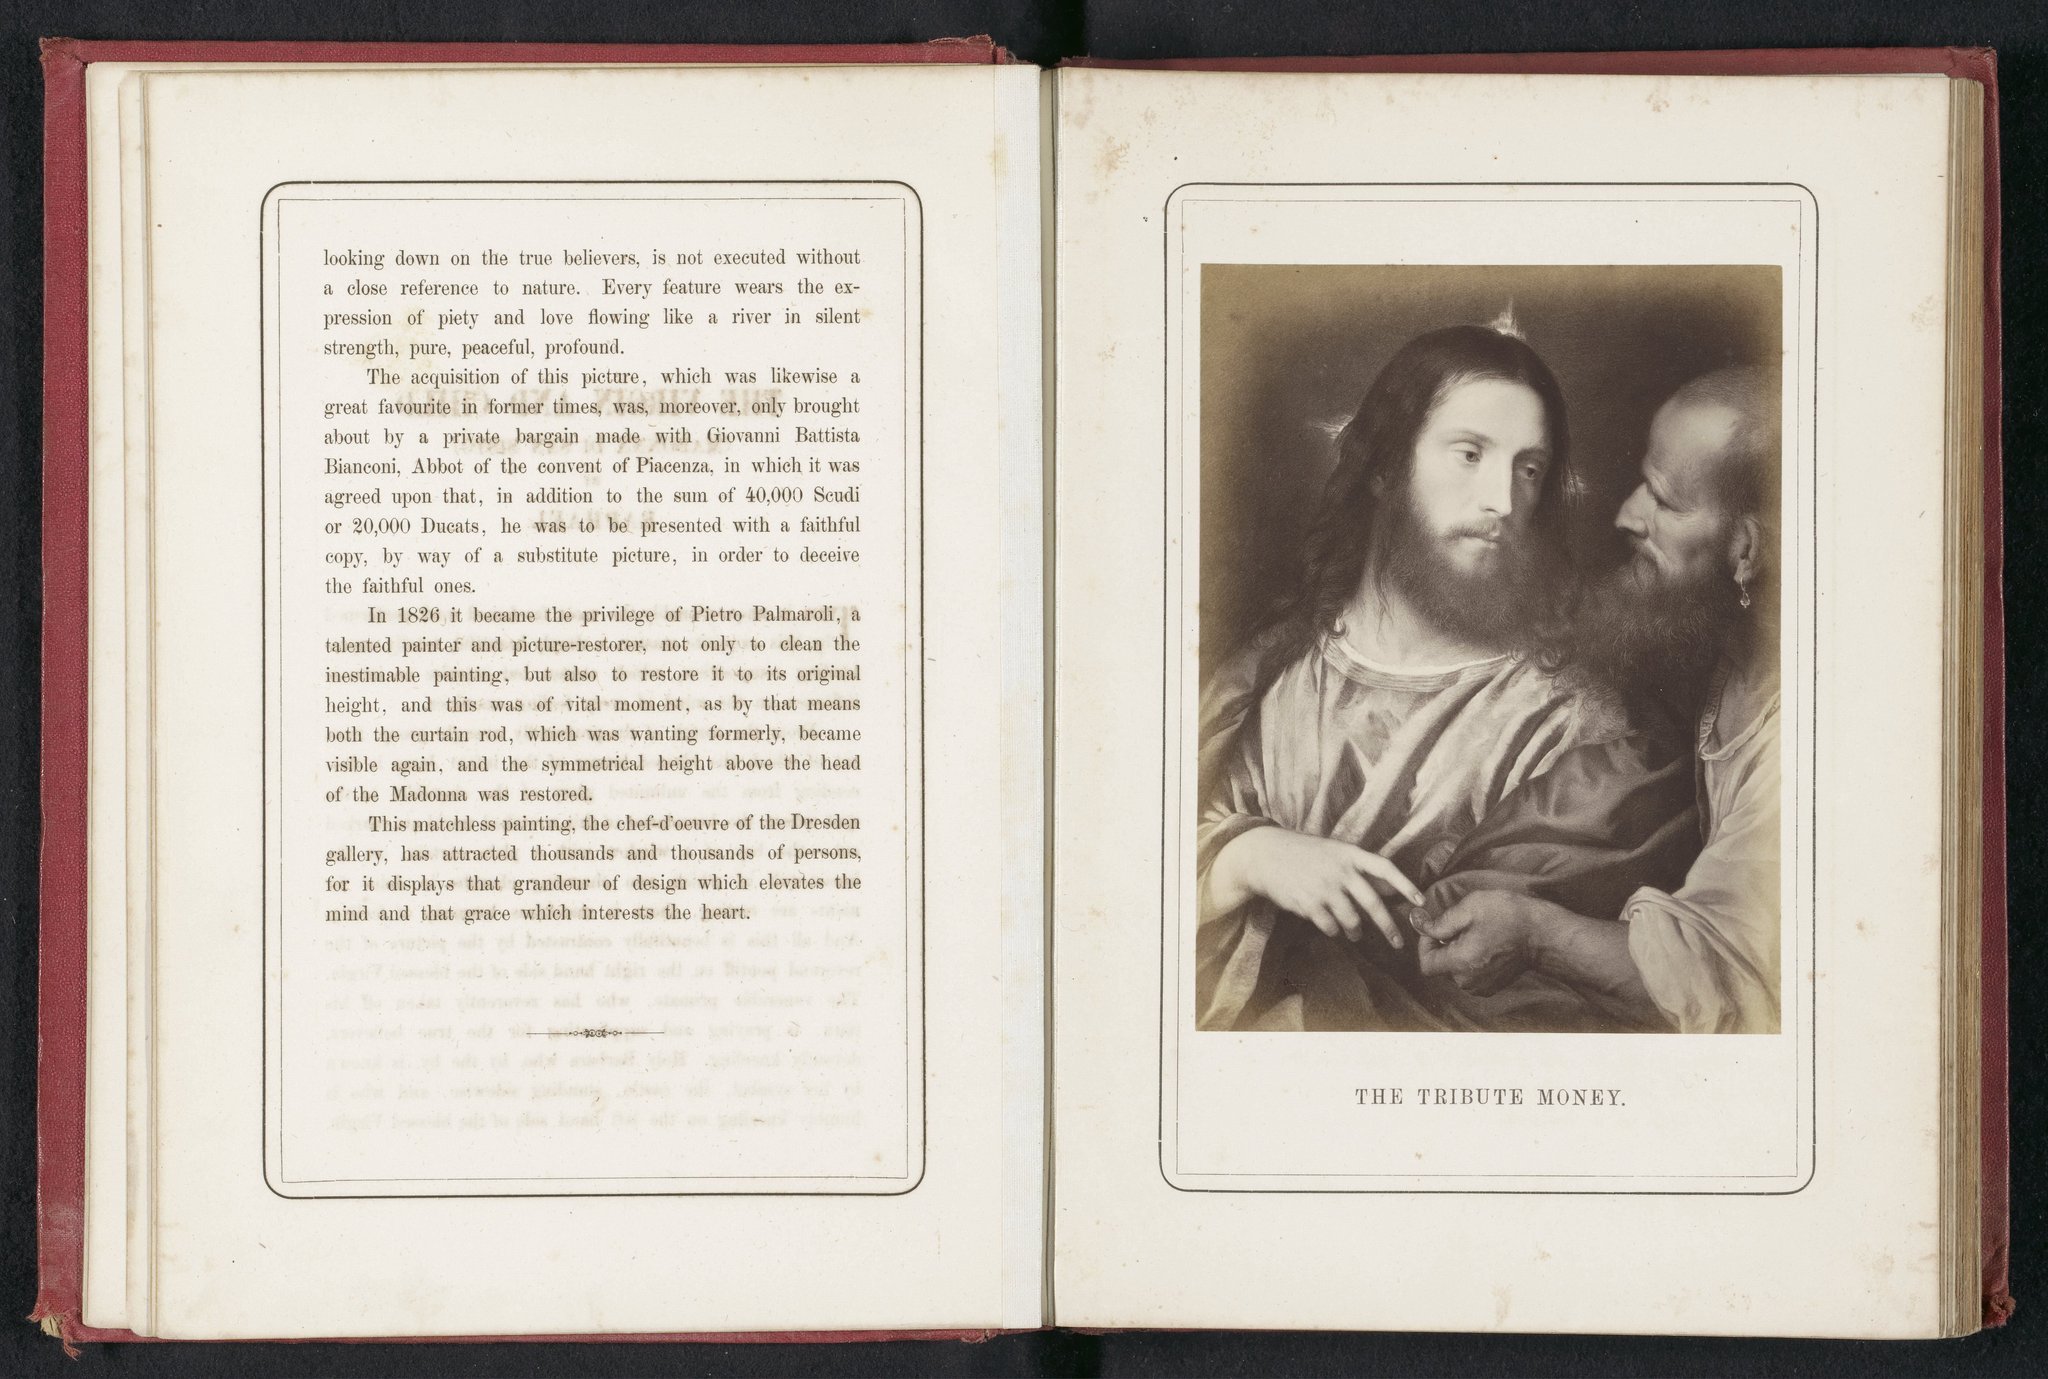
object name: reproduction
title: The Tribute Money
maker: hanns hanfstaengl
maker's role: print maker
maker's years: 1820-1885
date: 1854-1864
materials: photographic support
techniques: albumen print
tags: christ, picture, painting